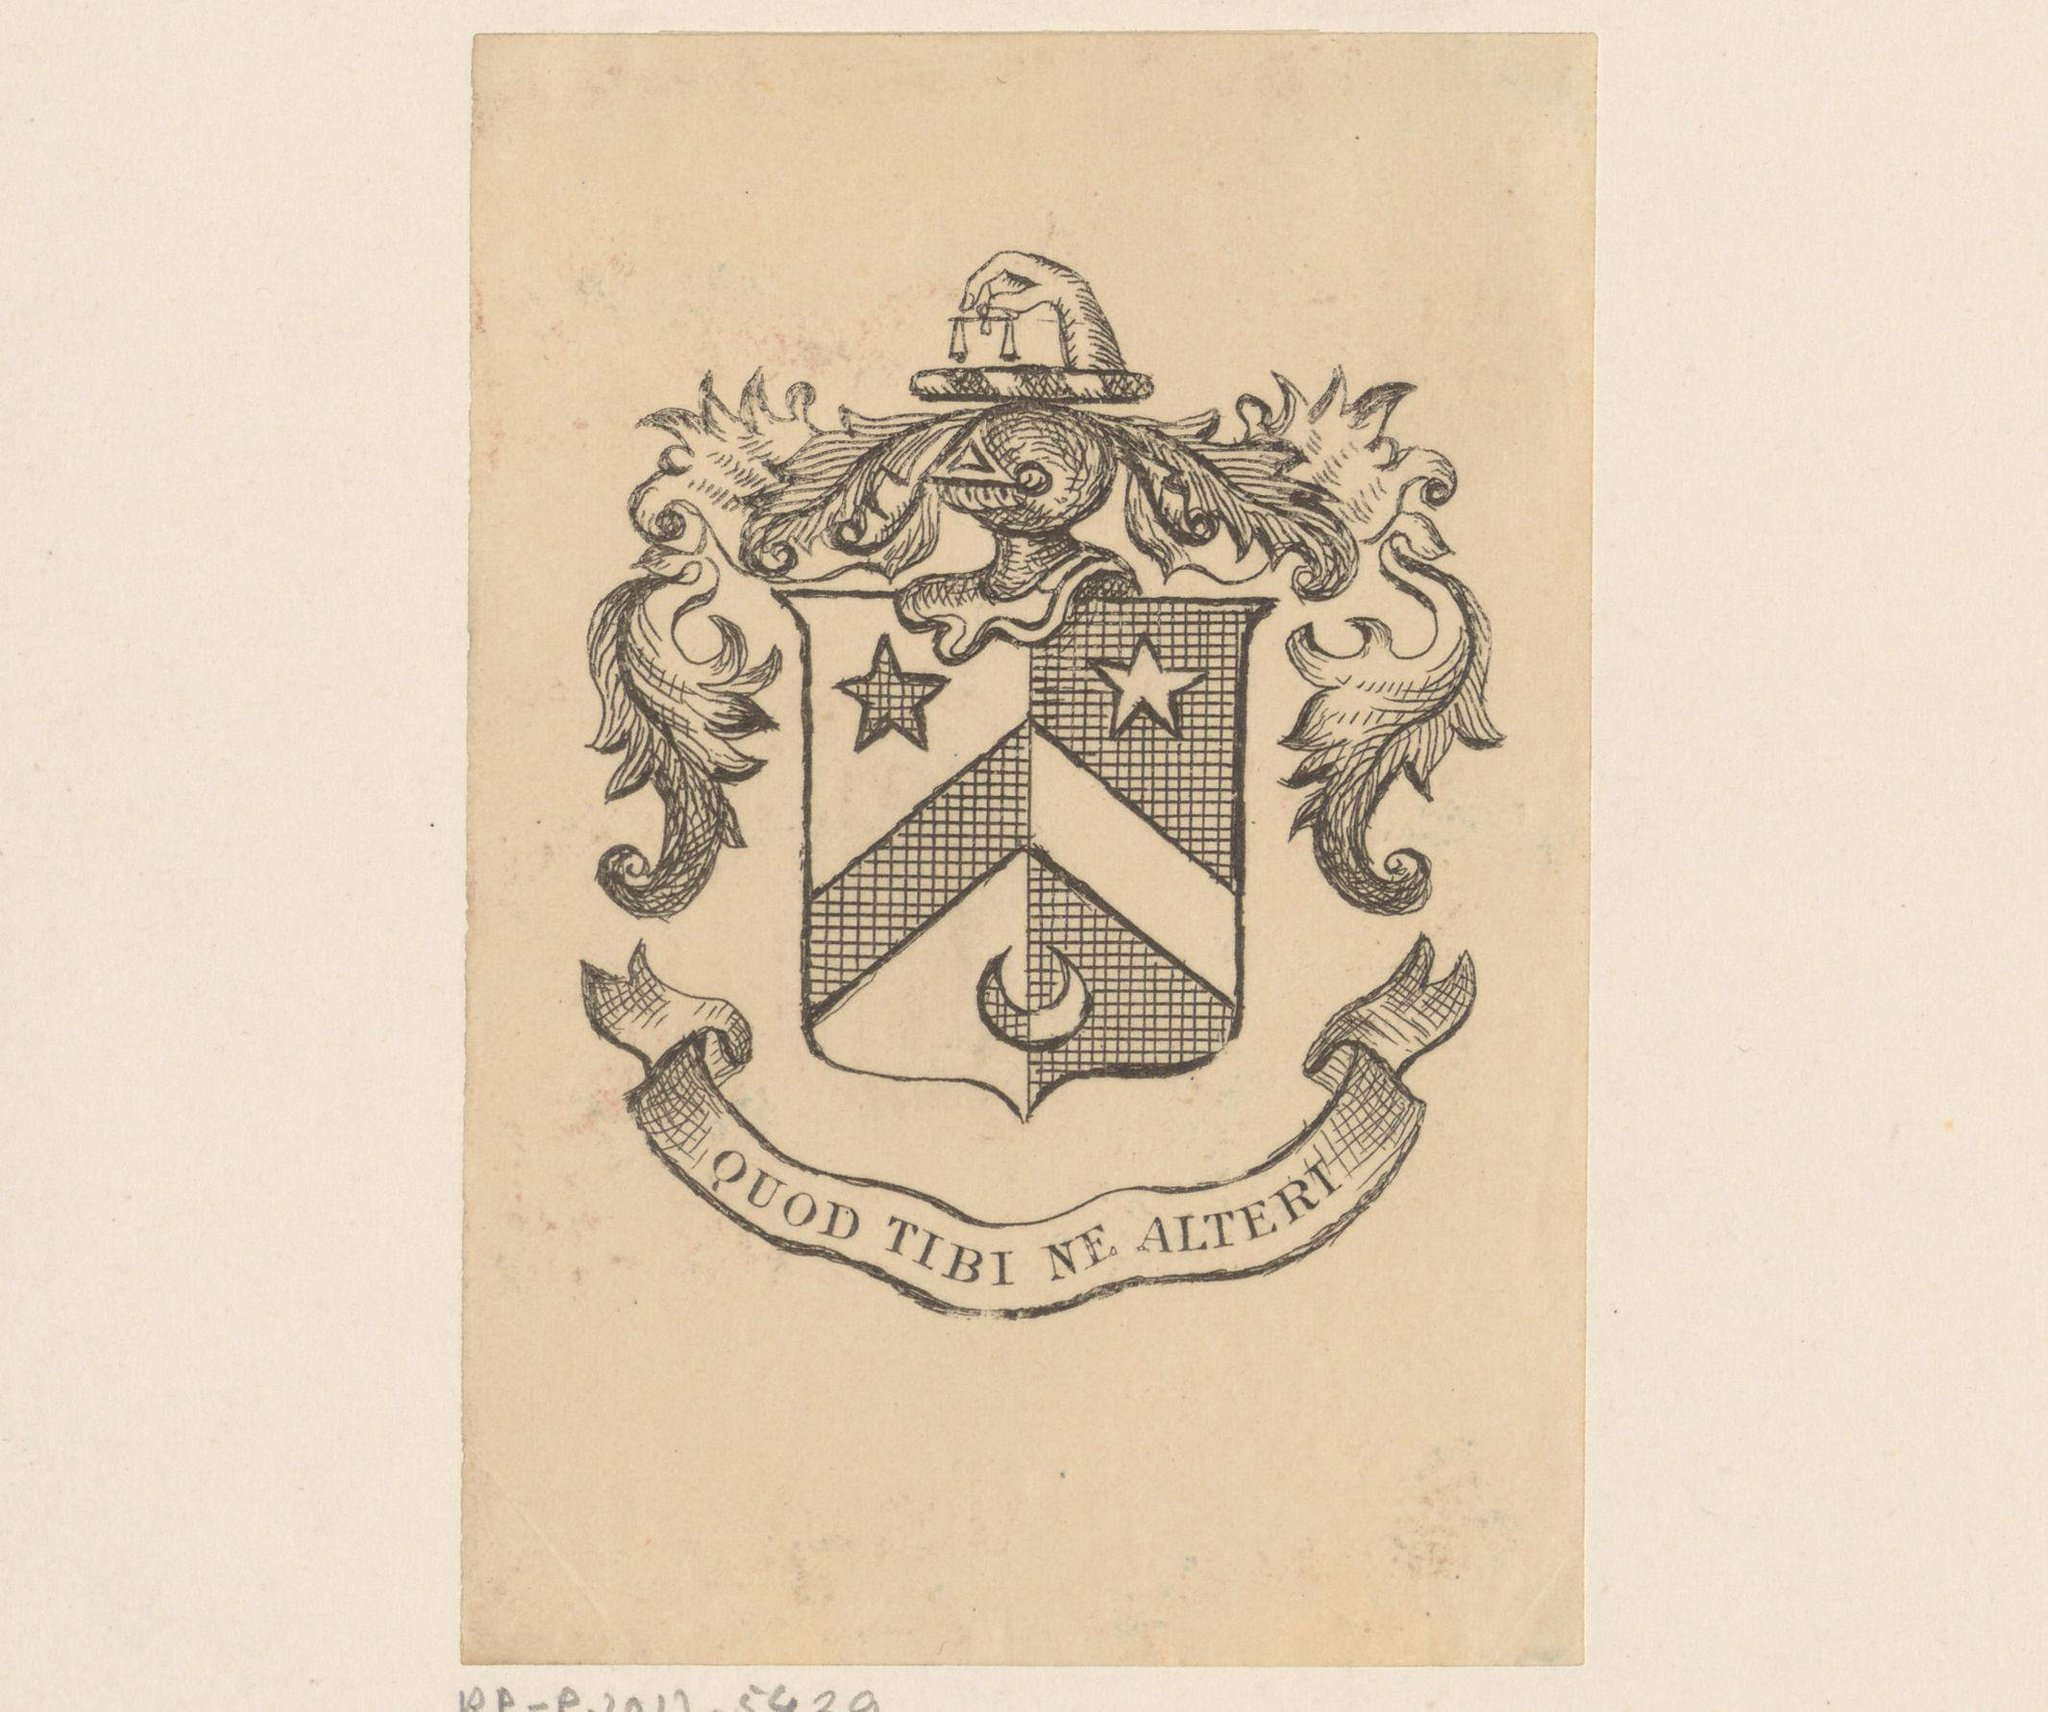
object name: bookplate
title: Ex libris van Alexander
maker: Anonymous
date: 1870-1923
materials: paper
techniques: printing block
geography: austria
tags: stars, armorial bearing, heraldry, weighing-instruments